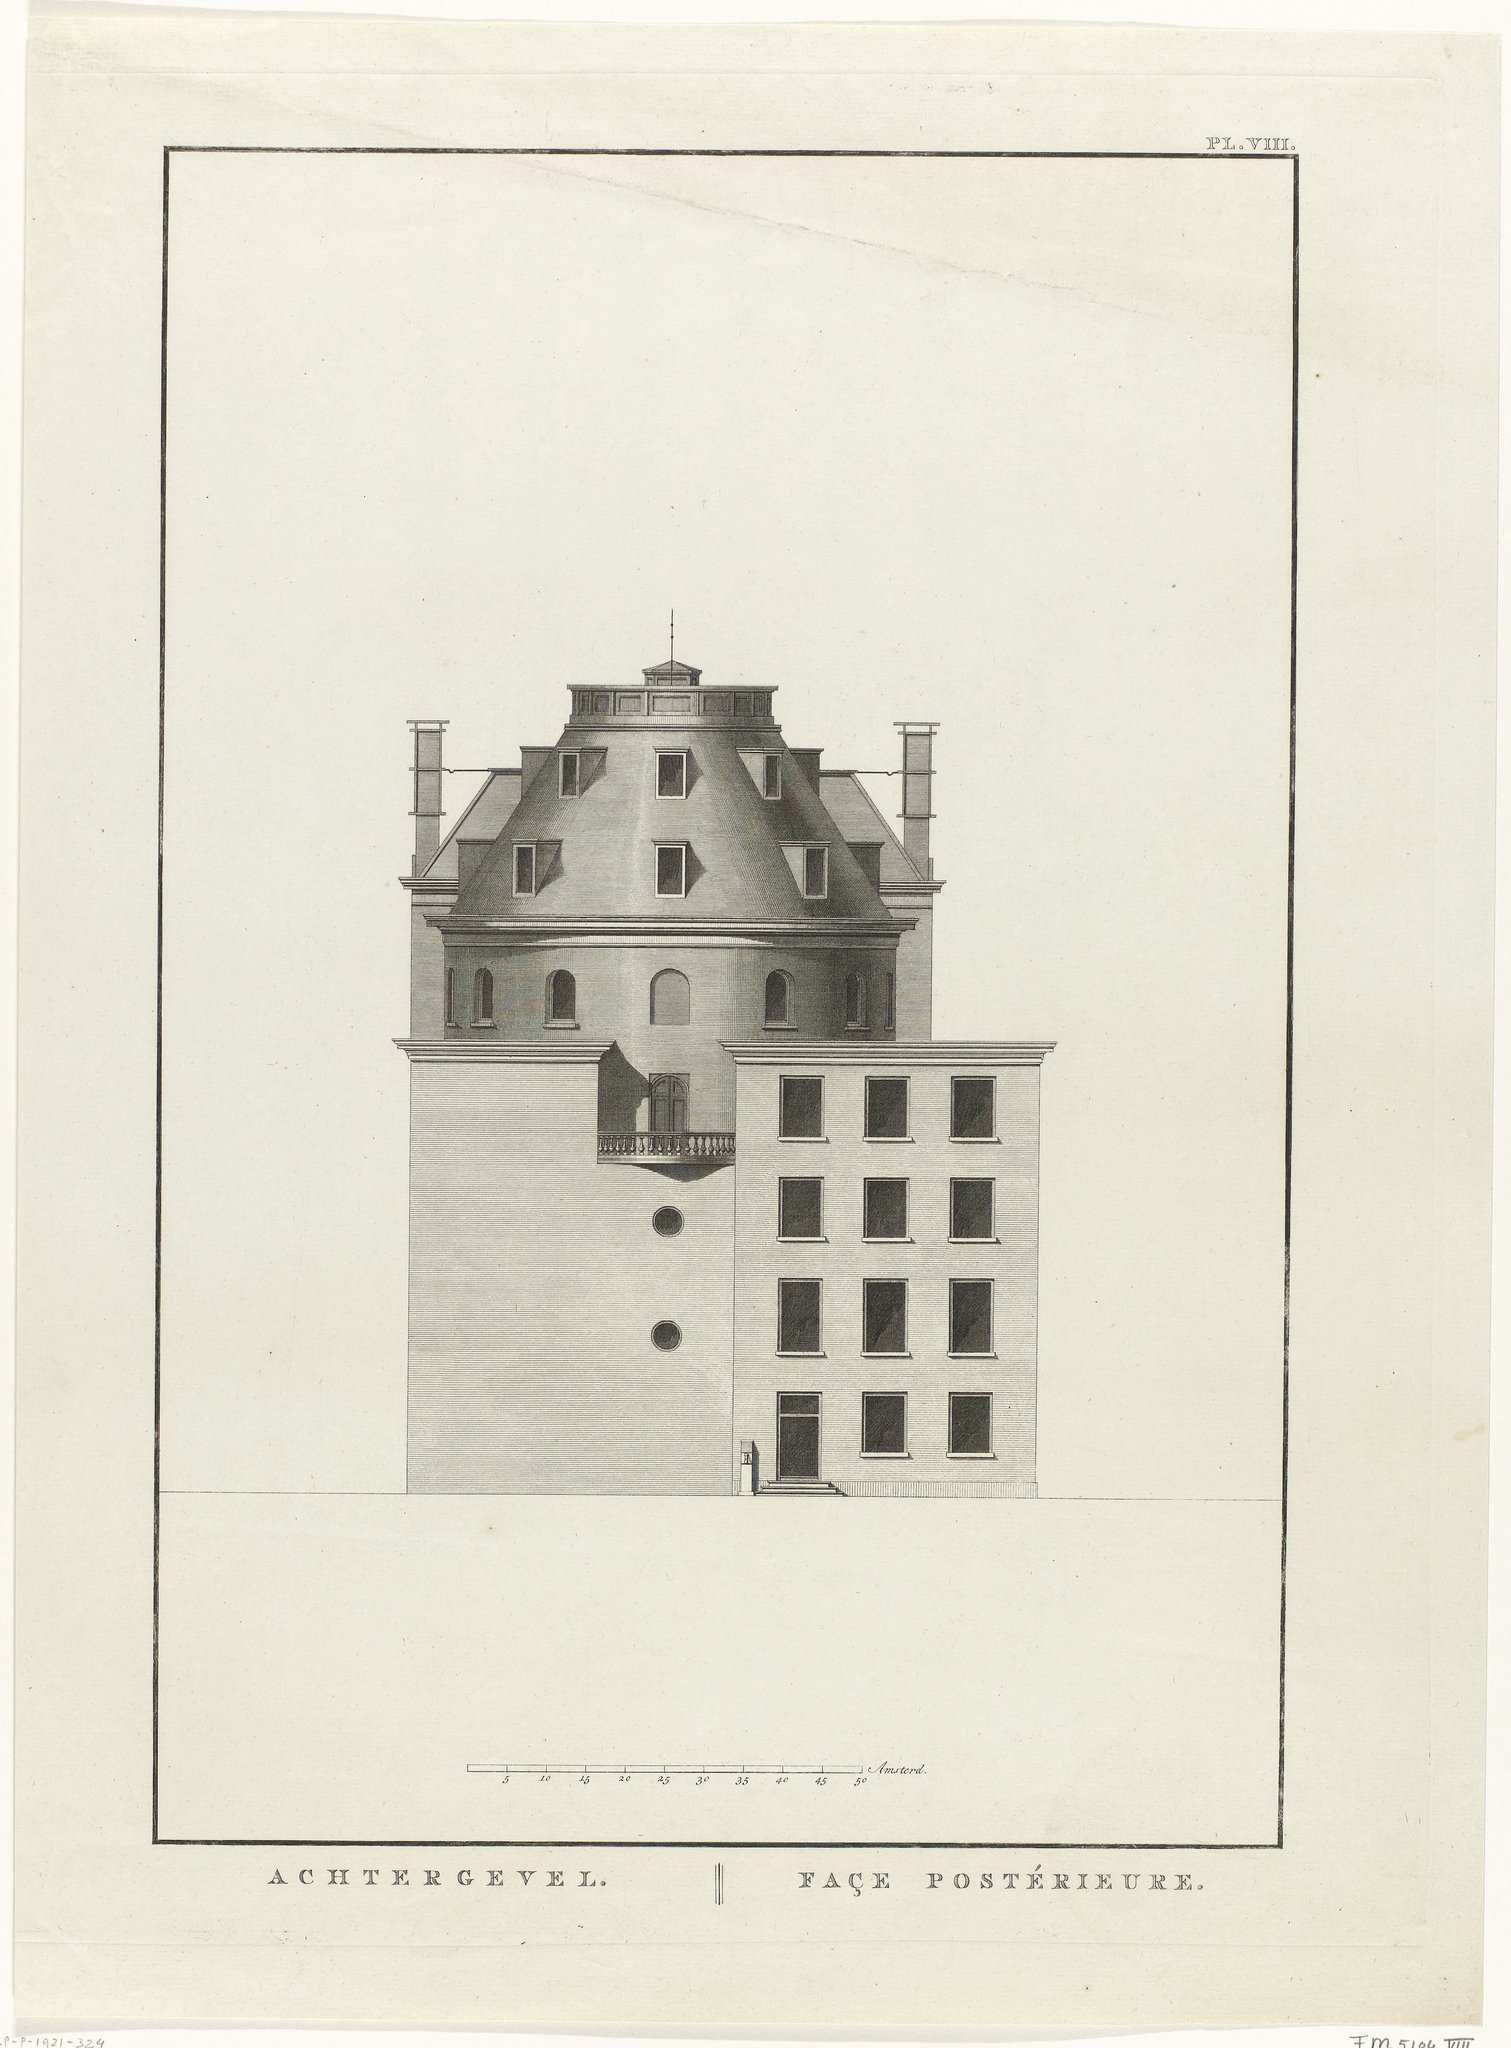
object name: print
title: Grondteekeningen van het Gebouw der Maatschappije van Verdiensten, ter spreuke voerende: Felix Meritis (...) / Détails d'architecture de l'edifice de la Société des Arts et des Sciences, sous la devise de Felix Meritis (...)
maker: noach van der meer (ii)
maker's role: draughtsman, print maker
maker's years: 1741-1822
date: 1789-1791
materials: paper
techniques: etching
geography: amsterdam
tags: jacob otten huslij, architectural design or model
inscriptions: collector's mark: Lugt 2233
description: Achtergevel van gebouw Felix Meritis te Amsterdam. Rechtsboven genummerd: Pl. VIII. Onderdeel van het plaatwerk over de architectuur van het gebouw voor de maatschappij Felix Meritis te Amsterdam, ontworpen door de achitect Jacob Otten Huslij en ingewijd op 31 oktober 1788.